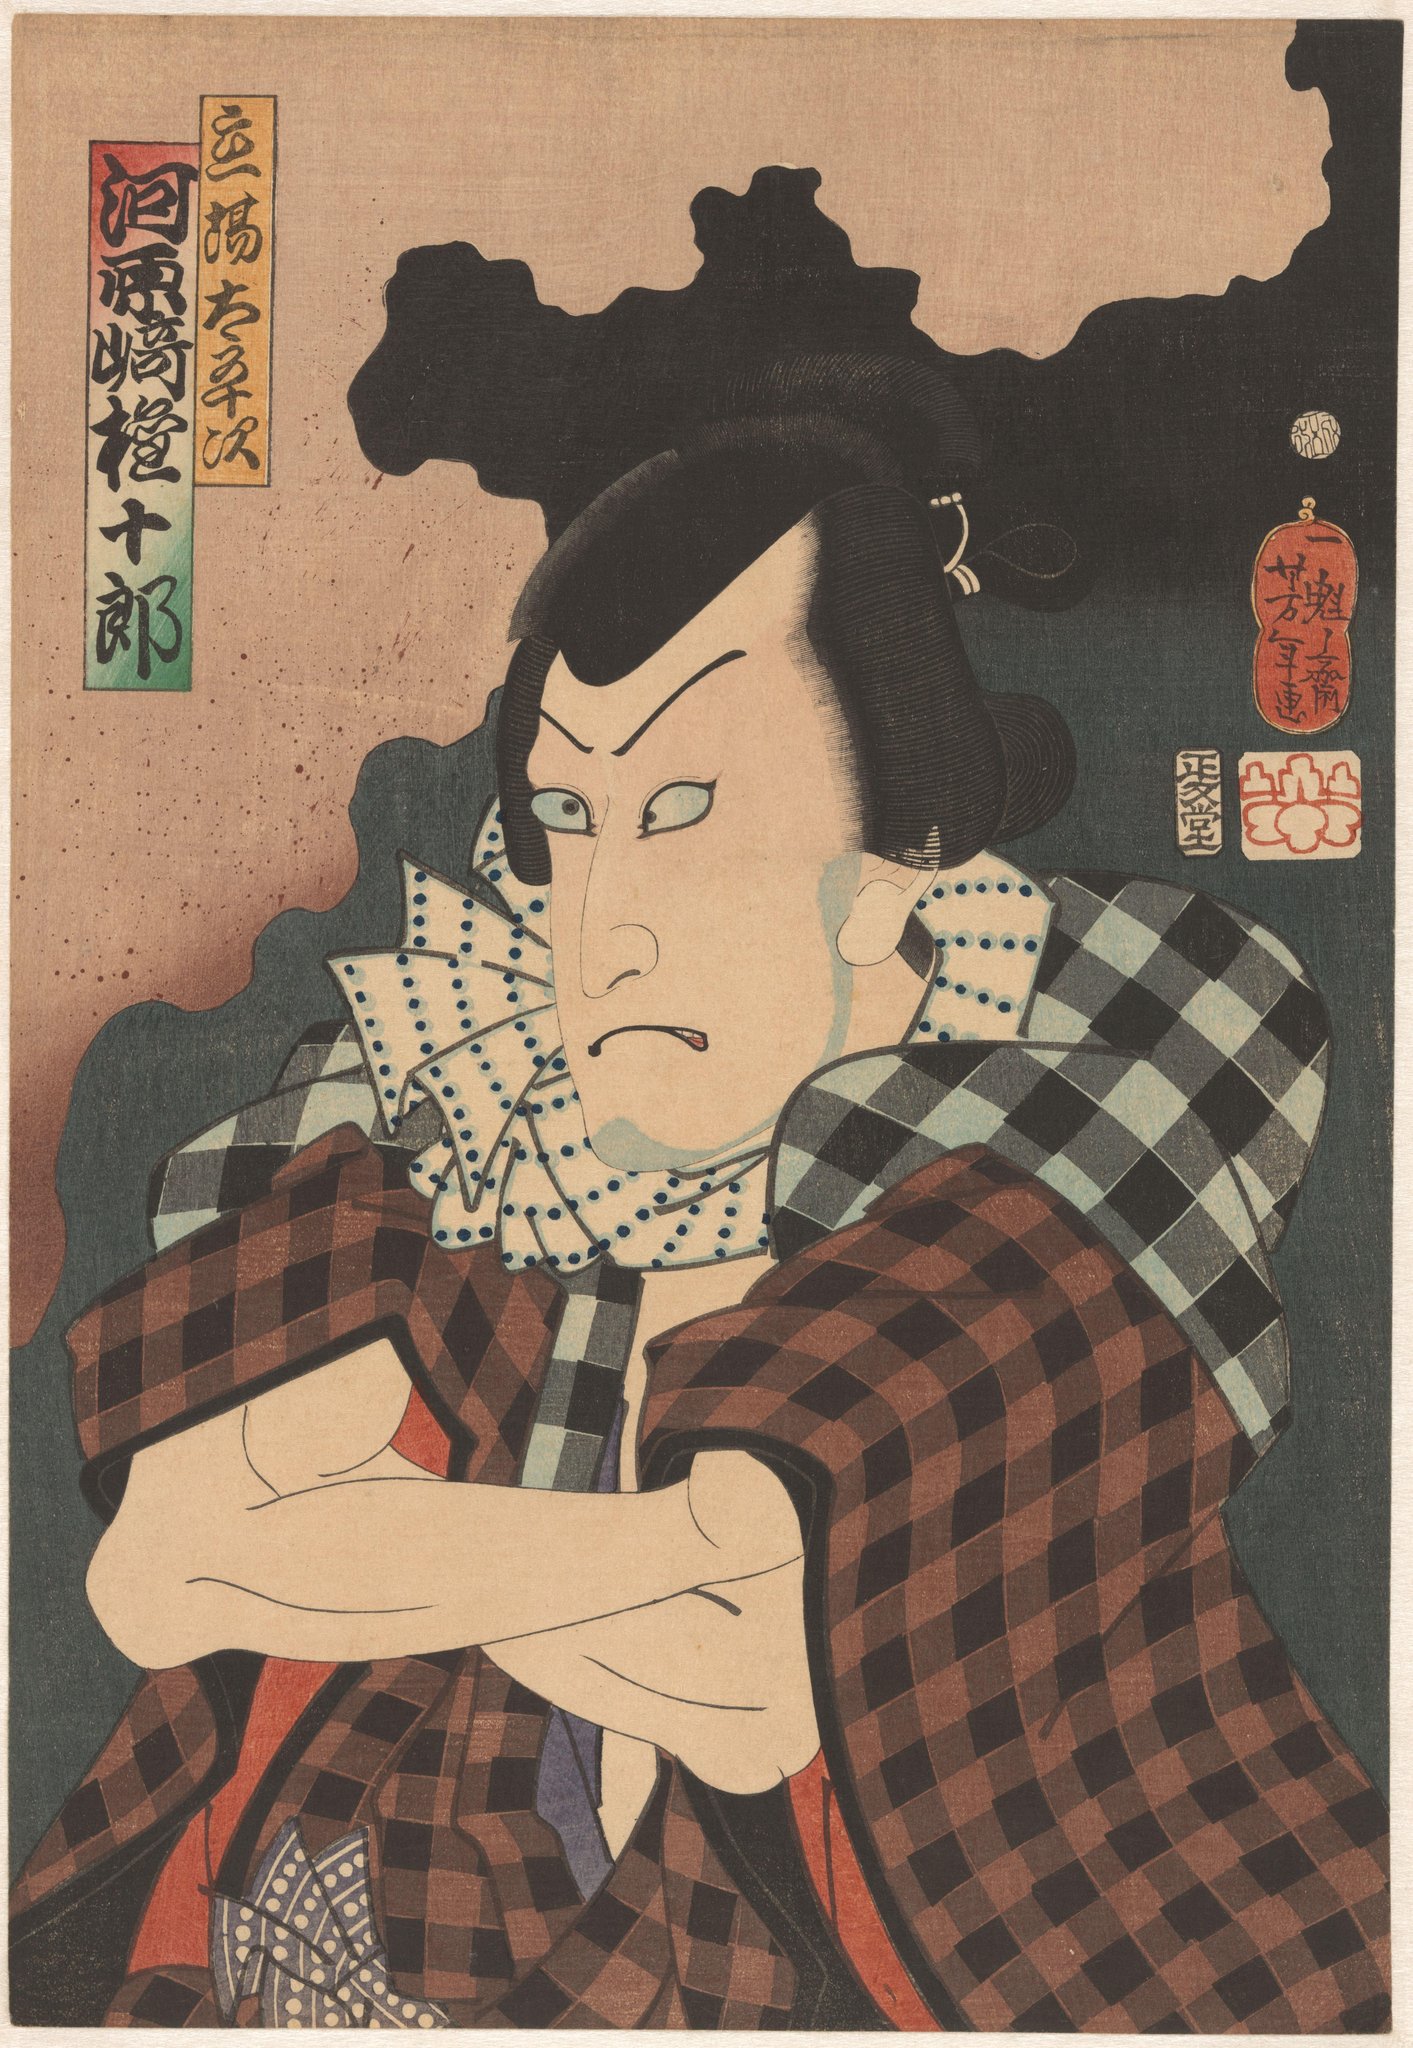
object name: print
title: Kabuki actor as the villain Tateba no Taheji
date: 1862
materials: paper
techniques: woodcut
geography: japan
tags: smoke, actor (on the stage)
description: Kabuki acteur Kawarasaki Gonjurô in de rol van de boef Tateba no Taheji. De rook op de achtergrond is afkomstig van de vuren die dragers op rustplaatsen (tateba) maakten om muggen te verjagen en verwijst dus naar de naam van de gespeelde boef: Tateba no Taheji. Scene uit het toneelstuk Shôbu awase adauchi kôdan, Gappo ga tsuji mono, voor het eerst opgevoerd in het Ichimura theater in mei 1810.